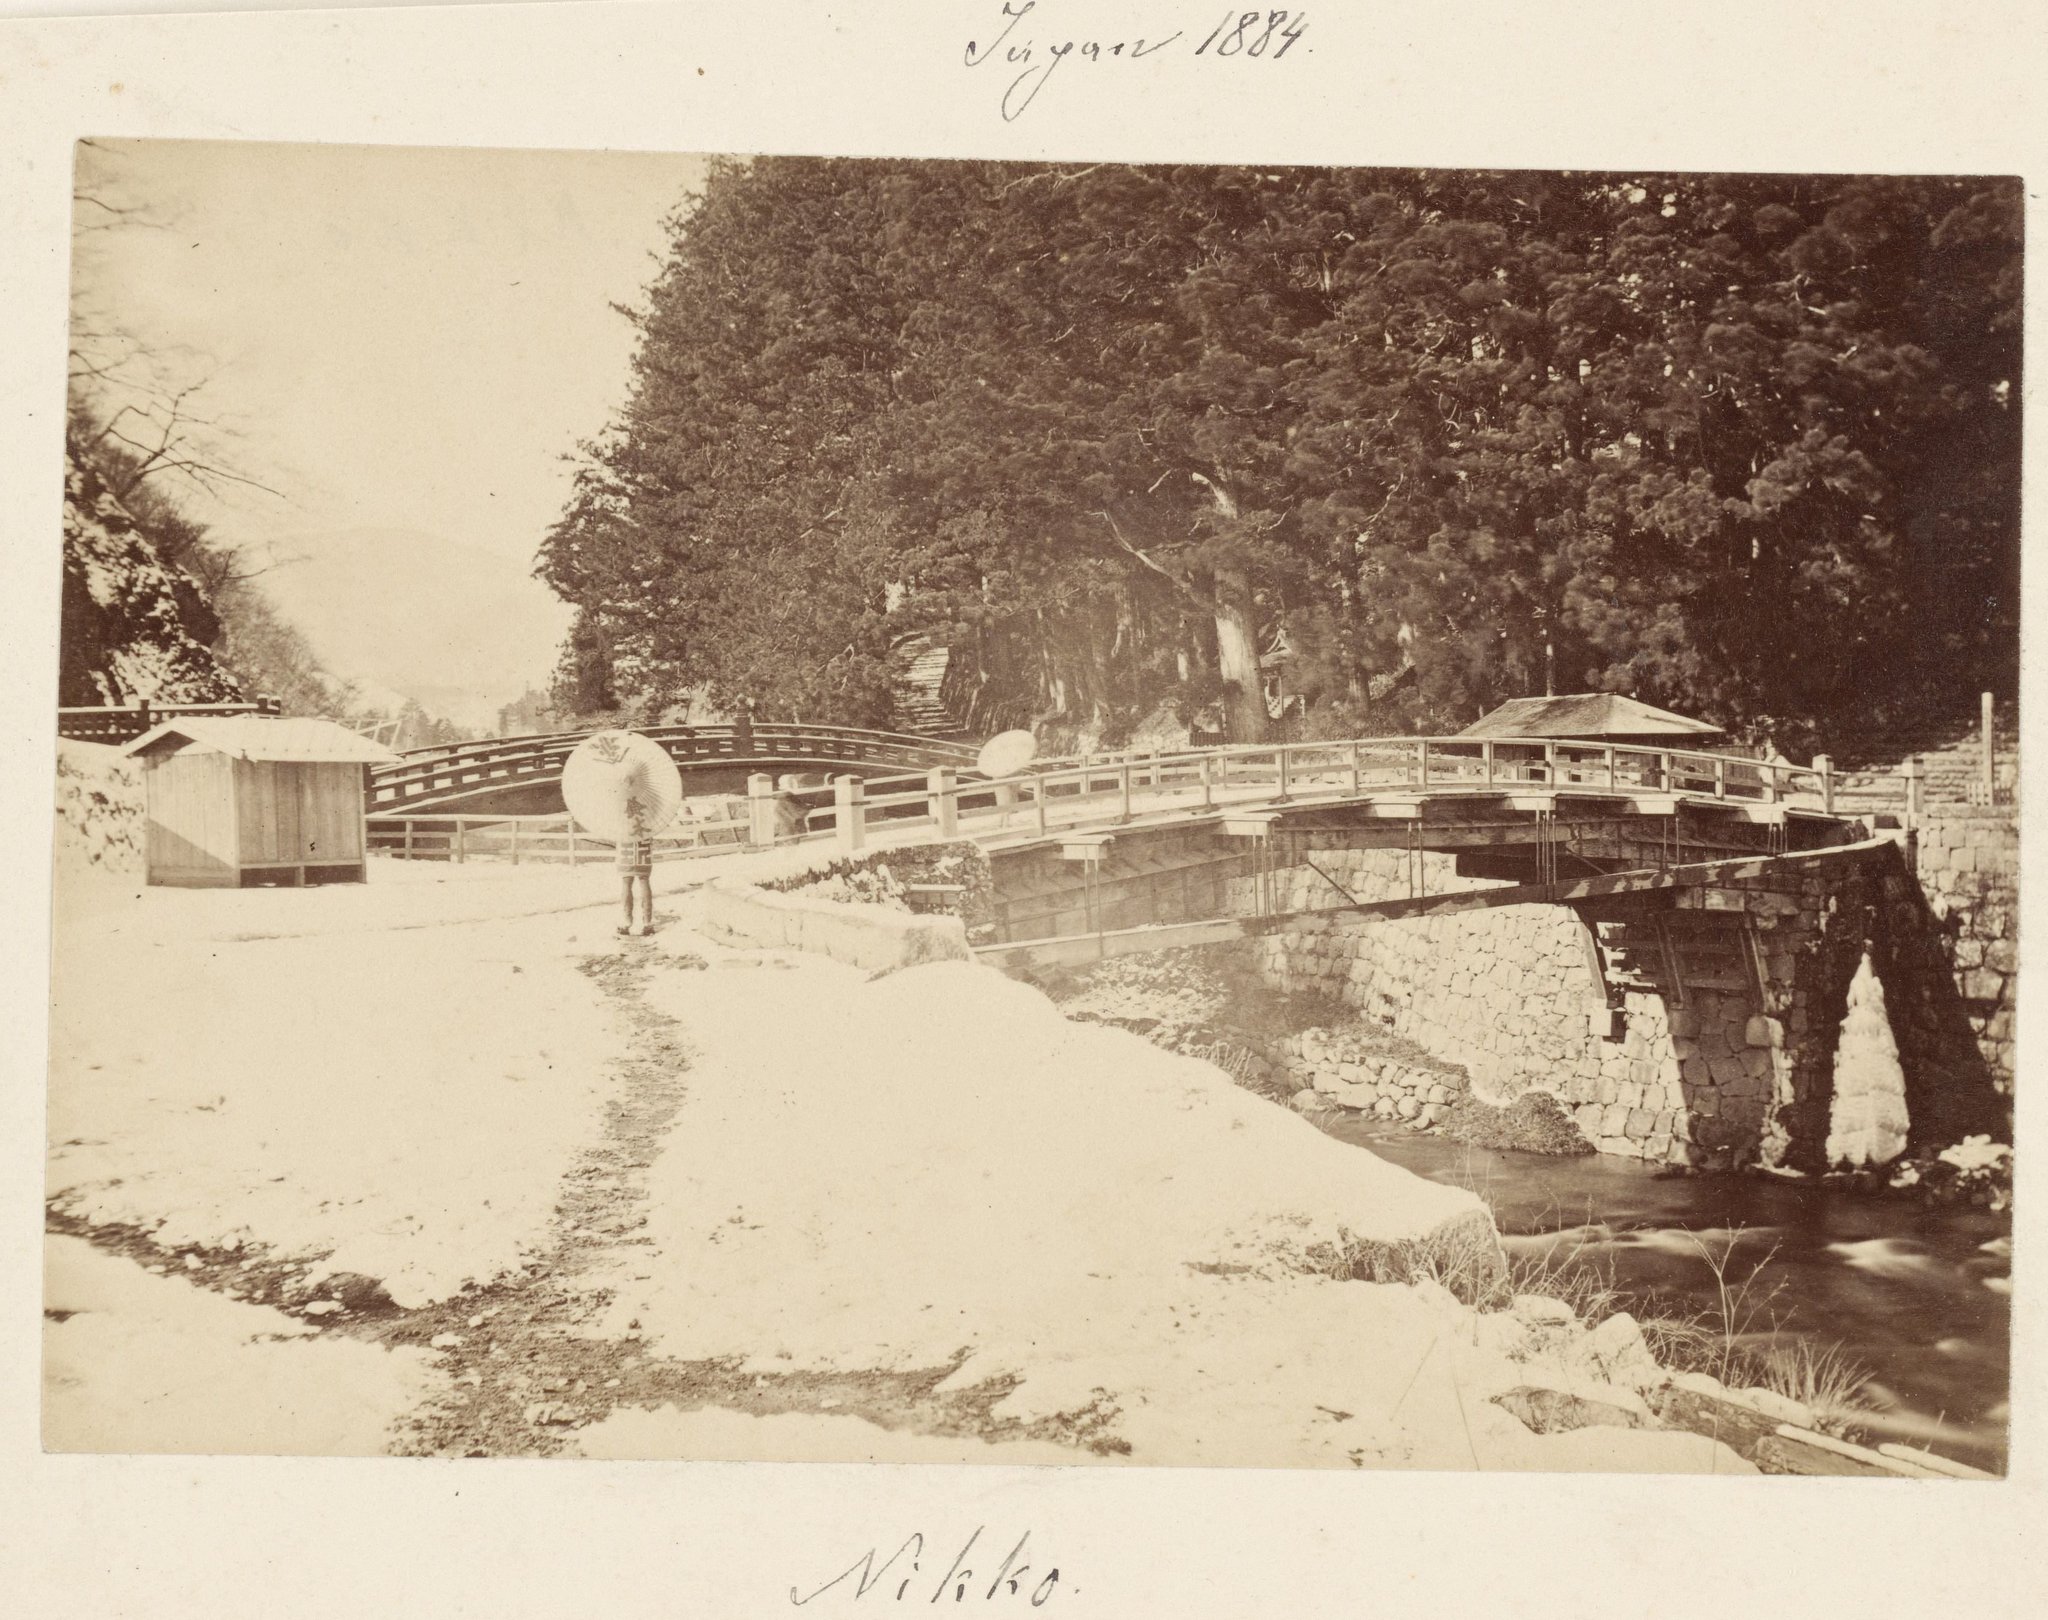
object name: photograph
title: Gezicht op twee bruggen over een rivier in Nikko, Japan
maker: Anonymous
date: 1884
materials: cardboard, paper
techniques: albumen print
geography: nikko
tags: river, bridge